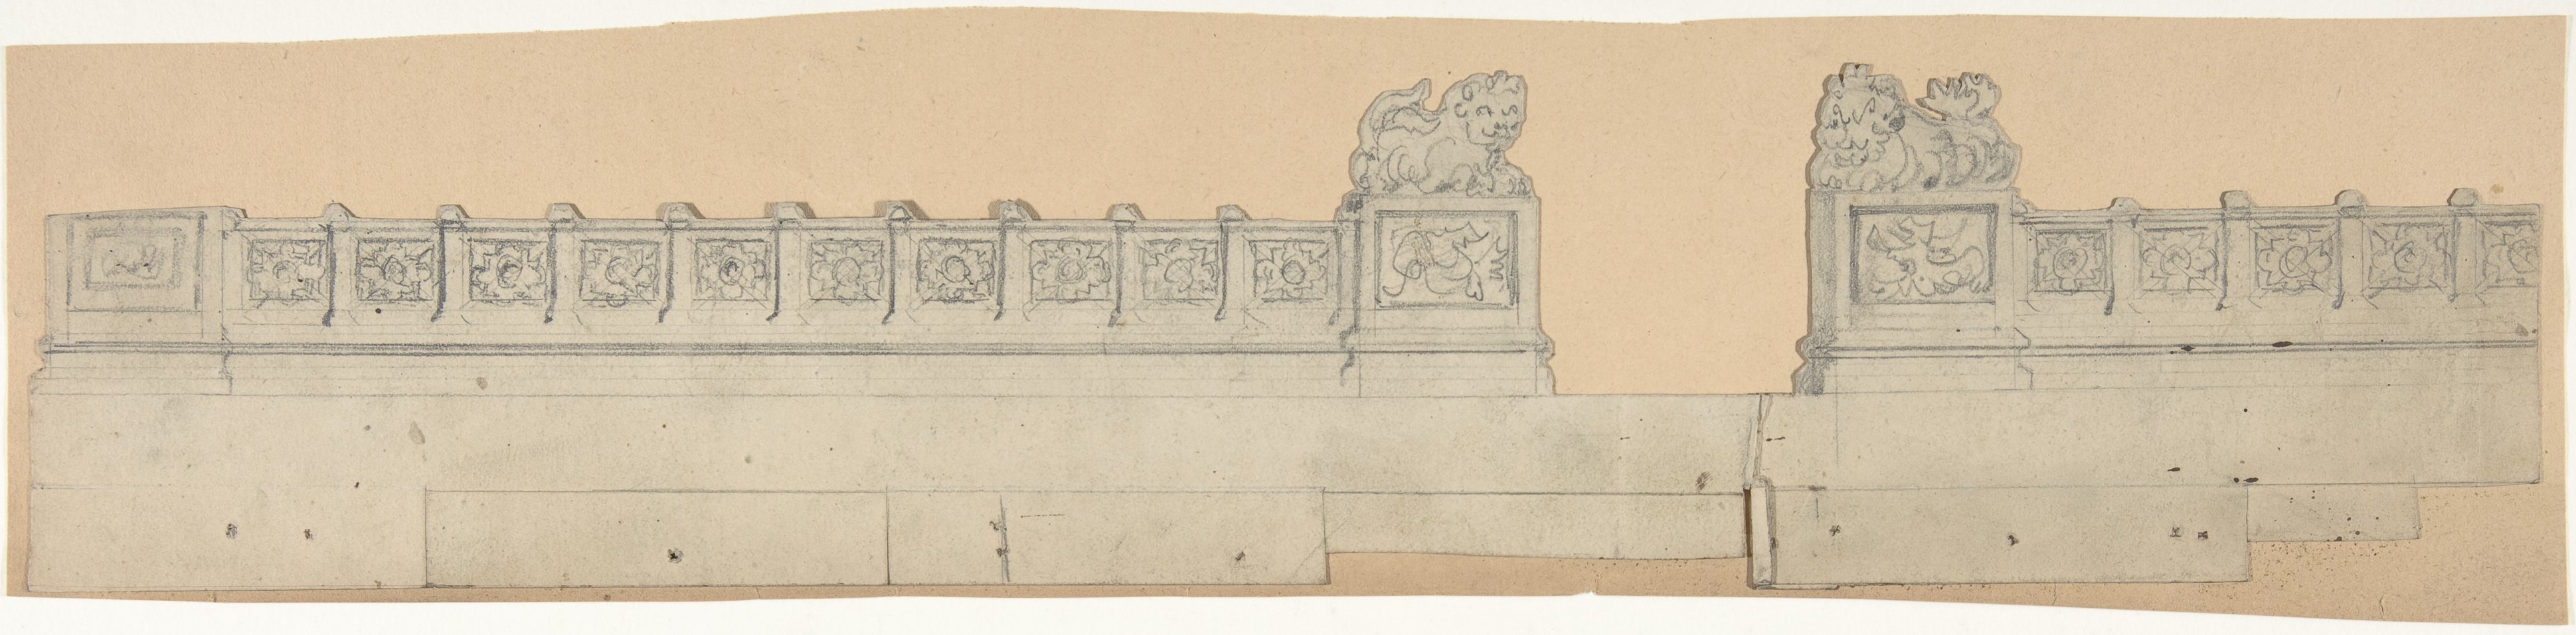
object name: drawing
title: Design for a Stage Set at the Opéra, Paris: Balustrade with Chinese Motif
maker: eugène cicéri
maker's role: artist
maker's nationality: french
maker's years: 1813-1890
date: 1830-1890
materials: graphite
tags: lions,stage design